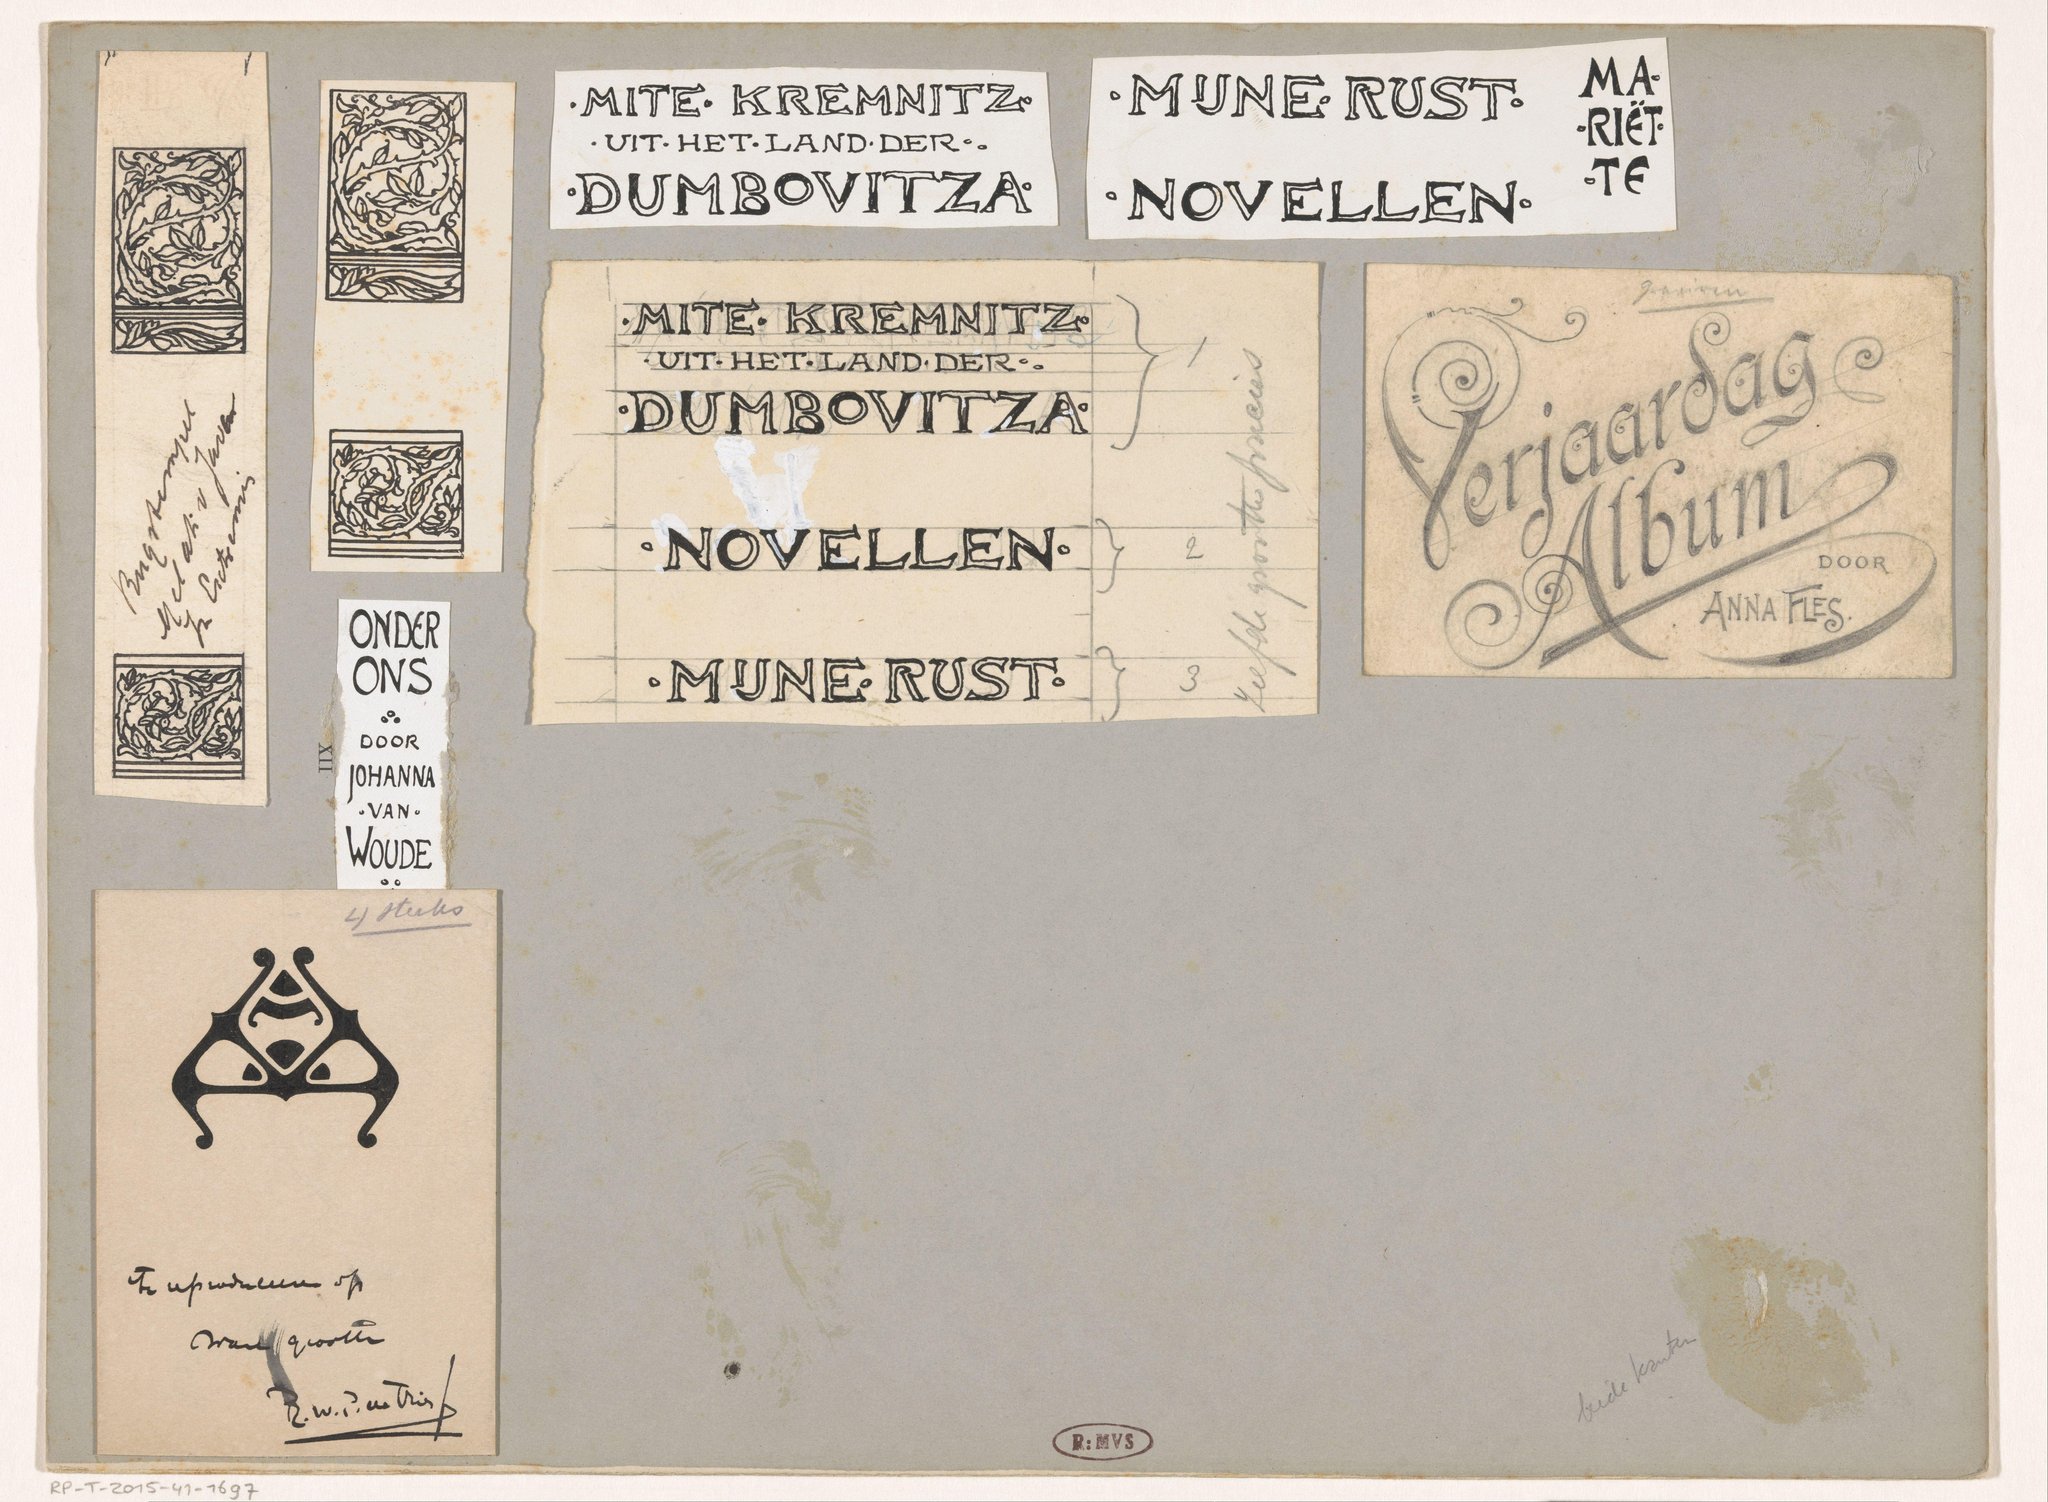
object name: study for binding design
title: Bandontwerpen en een ornament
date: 1896-1899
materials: cardboard, paint, ink, paper, pencil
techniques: brush, pen, printing block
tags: ornaments ~ art, fancy letters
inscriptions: collector's mark: Lugt 2228, annotation: ‘beide kanten’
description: Ontwerp voor de boekrug voor In extremis (c. 1896-1897) door Melati van Java. Tevens ontwerpen voor Verjaardagsalbum (datum onbekend) door Anna Fles, Onder ons (1890) van Johanna van Woude en Mijne rust (1899) door Carmen Sylva.